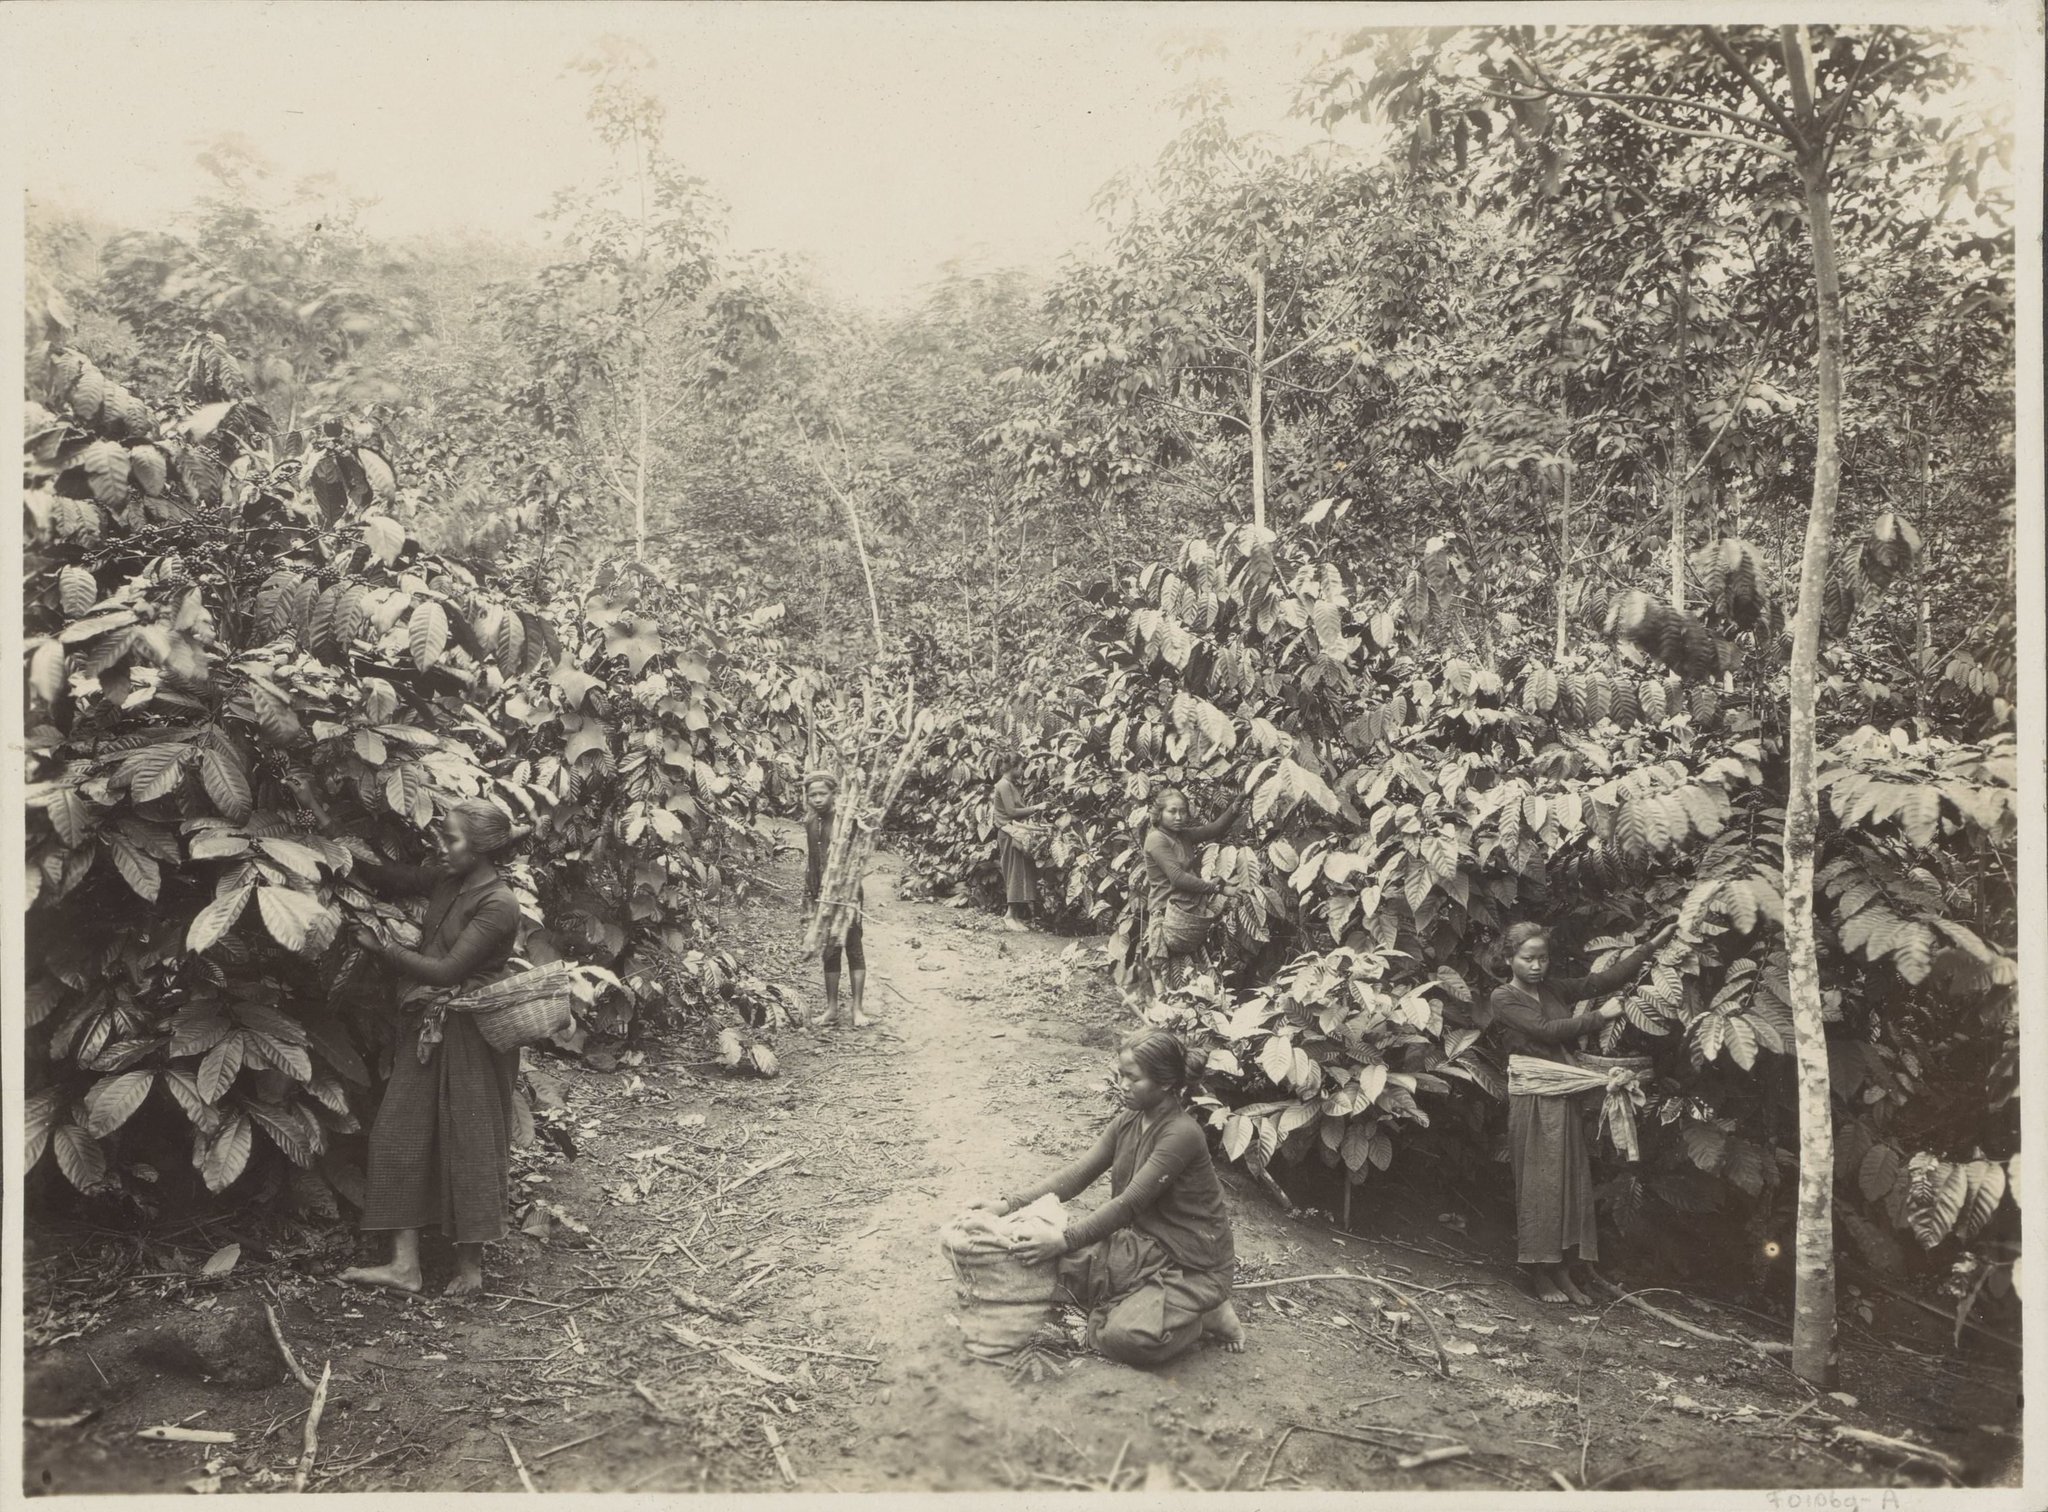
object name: photograph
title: Vrouwen aan het werk op een plantage in Nederlands-Indië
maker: onnes kurkdjian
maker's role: fotograaf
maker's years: 1851-1903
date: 1912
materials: paper, photographic support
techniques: gelatin silver print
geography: dutch east indies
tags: plantation, dutch east indies, the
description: Onderdeel van Reisalbum met veertig foto's van Nederlands-Indië.